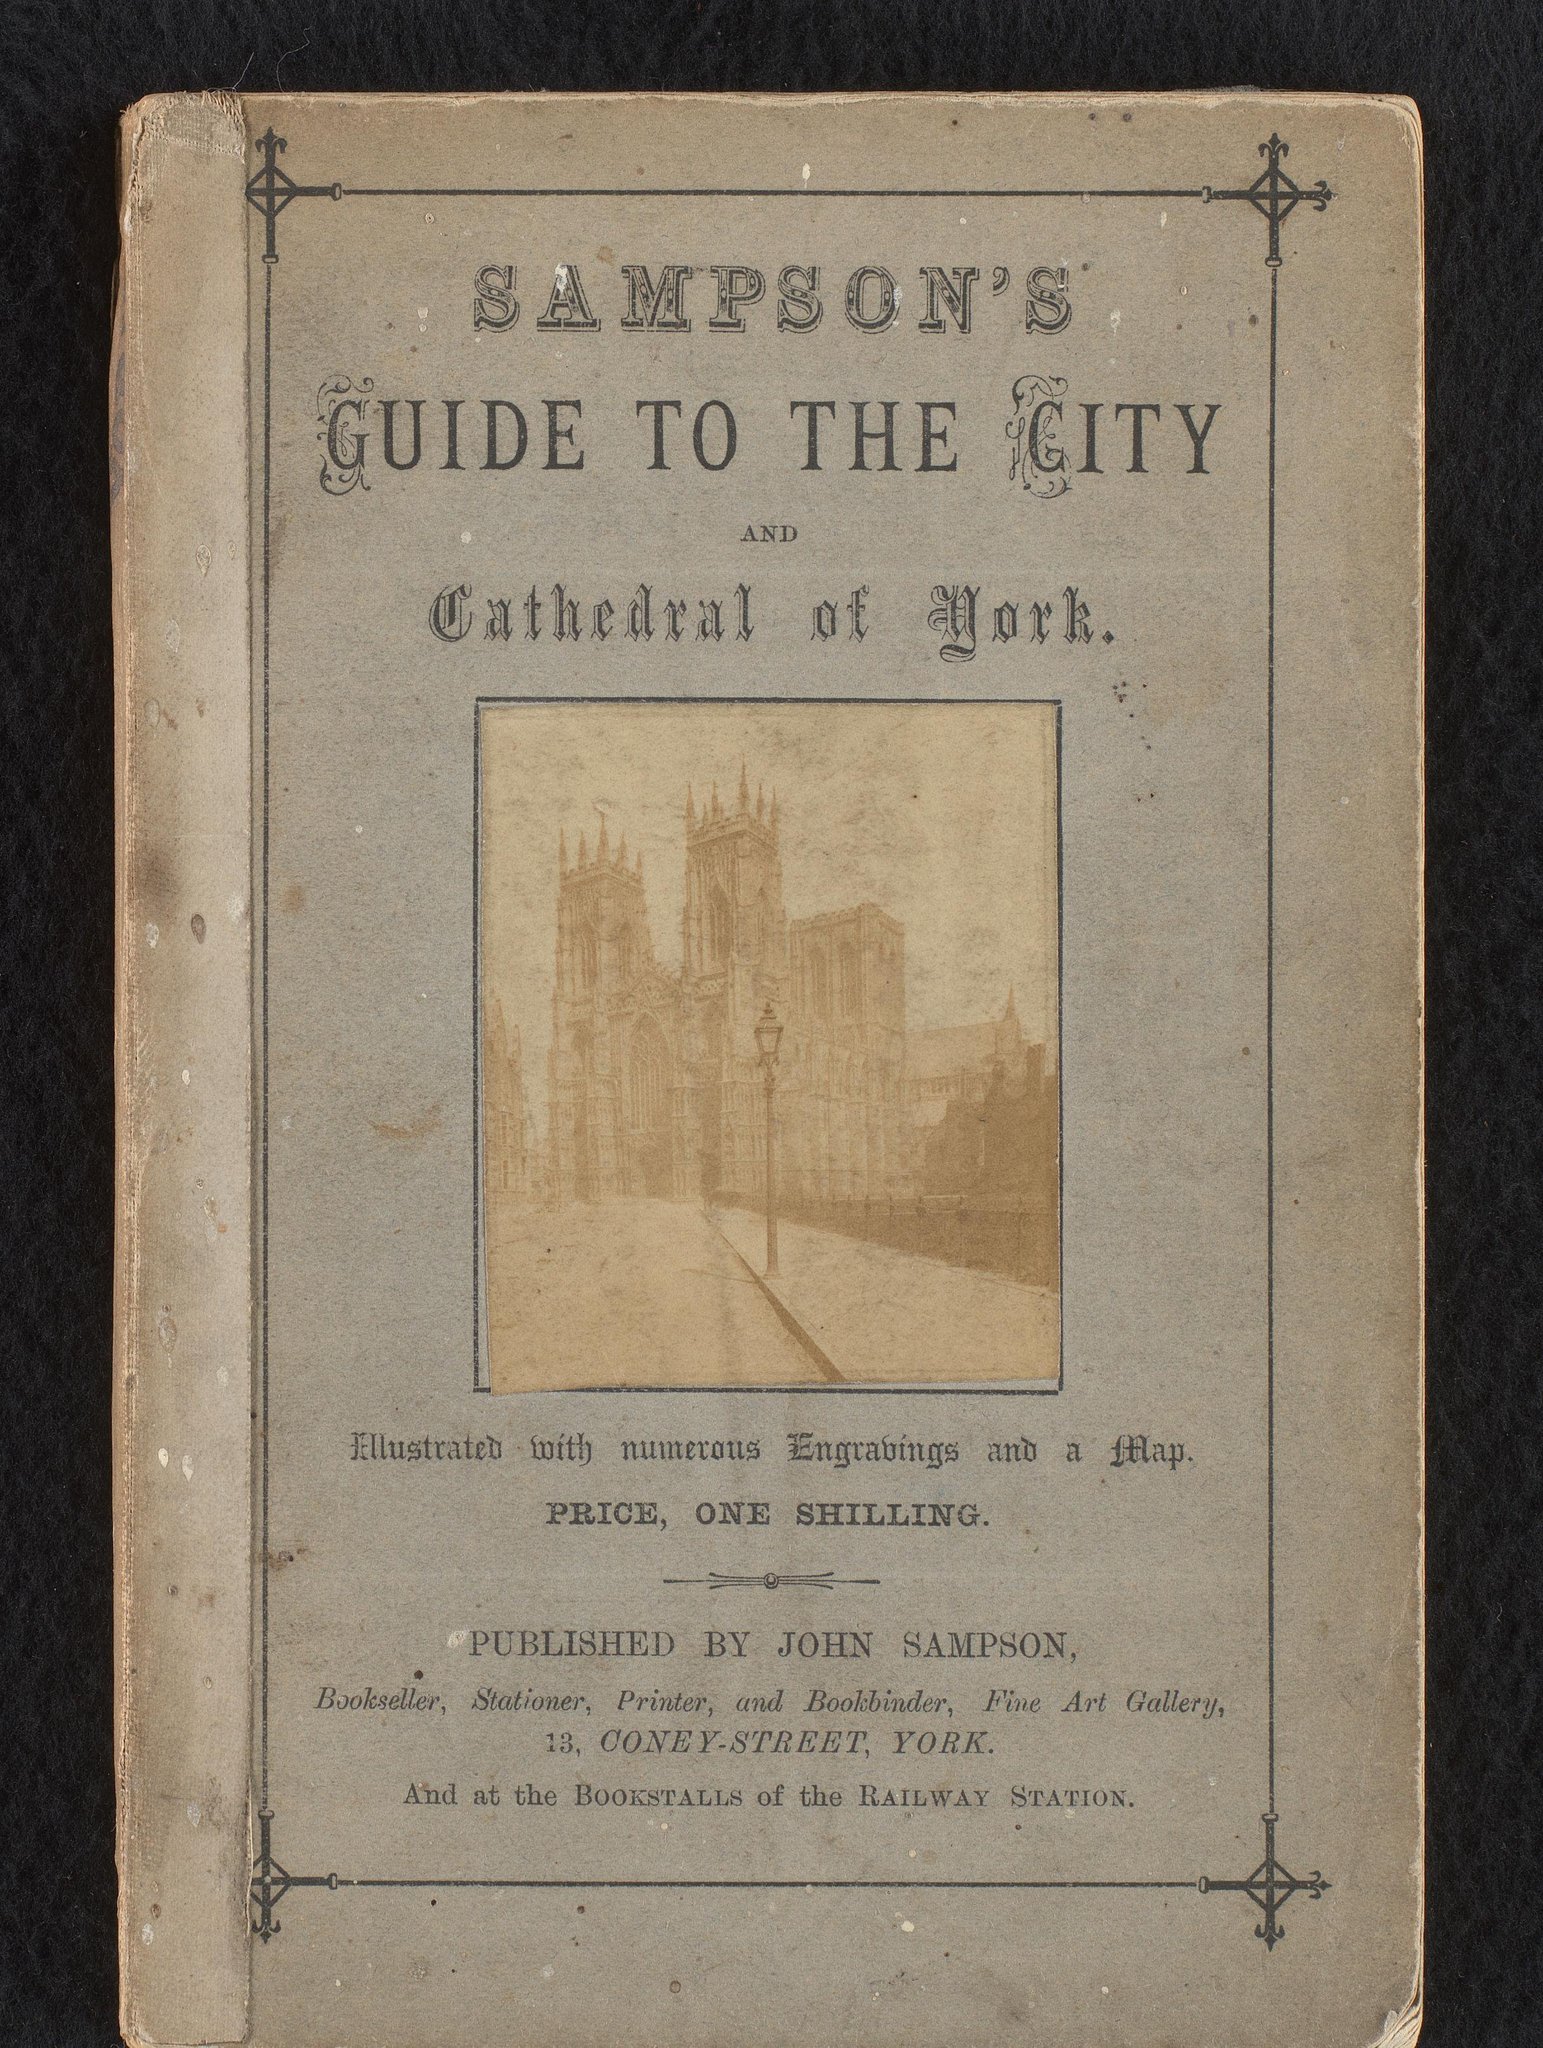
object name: book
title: Sampson's Guide to the City and Cathedral of York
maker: john sampson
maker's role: bookseller, printer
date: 1875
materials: paper, textile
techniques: albumen print, letterpress printing, line block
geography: york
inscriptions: date: ‘SEPT 2015’